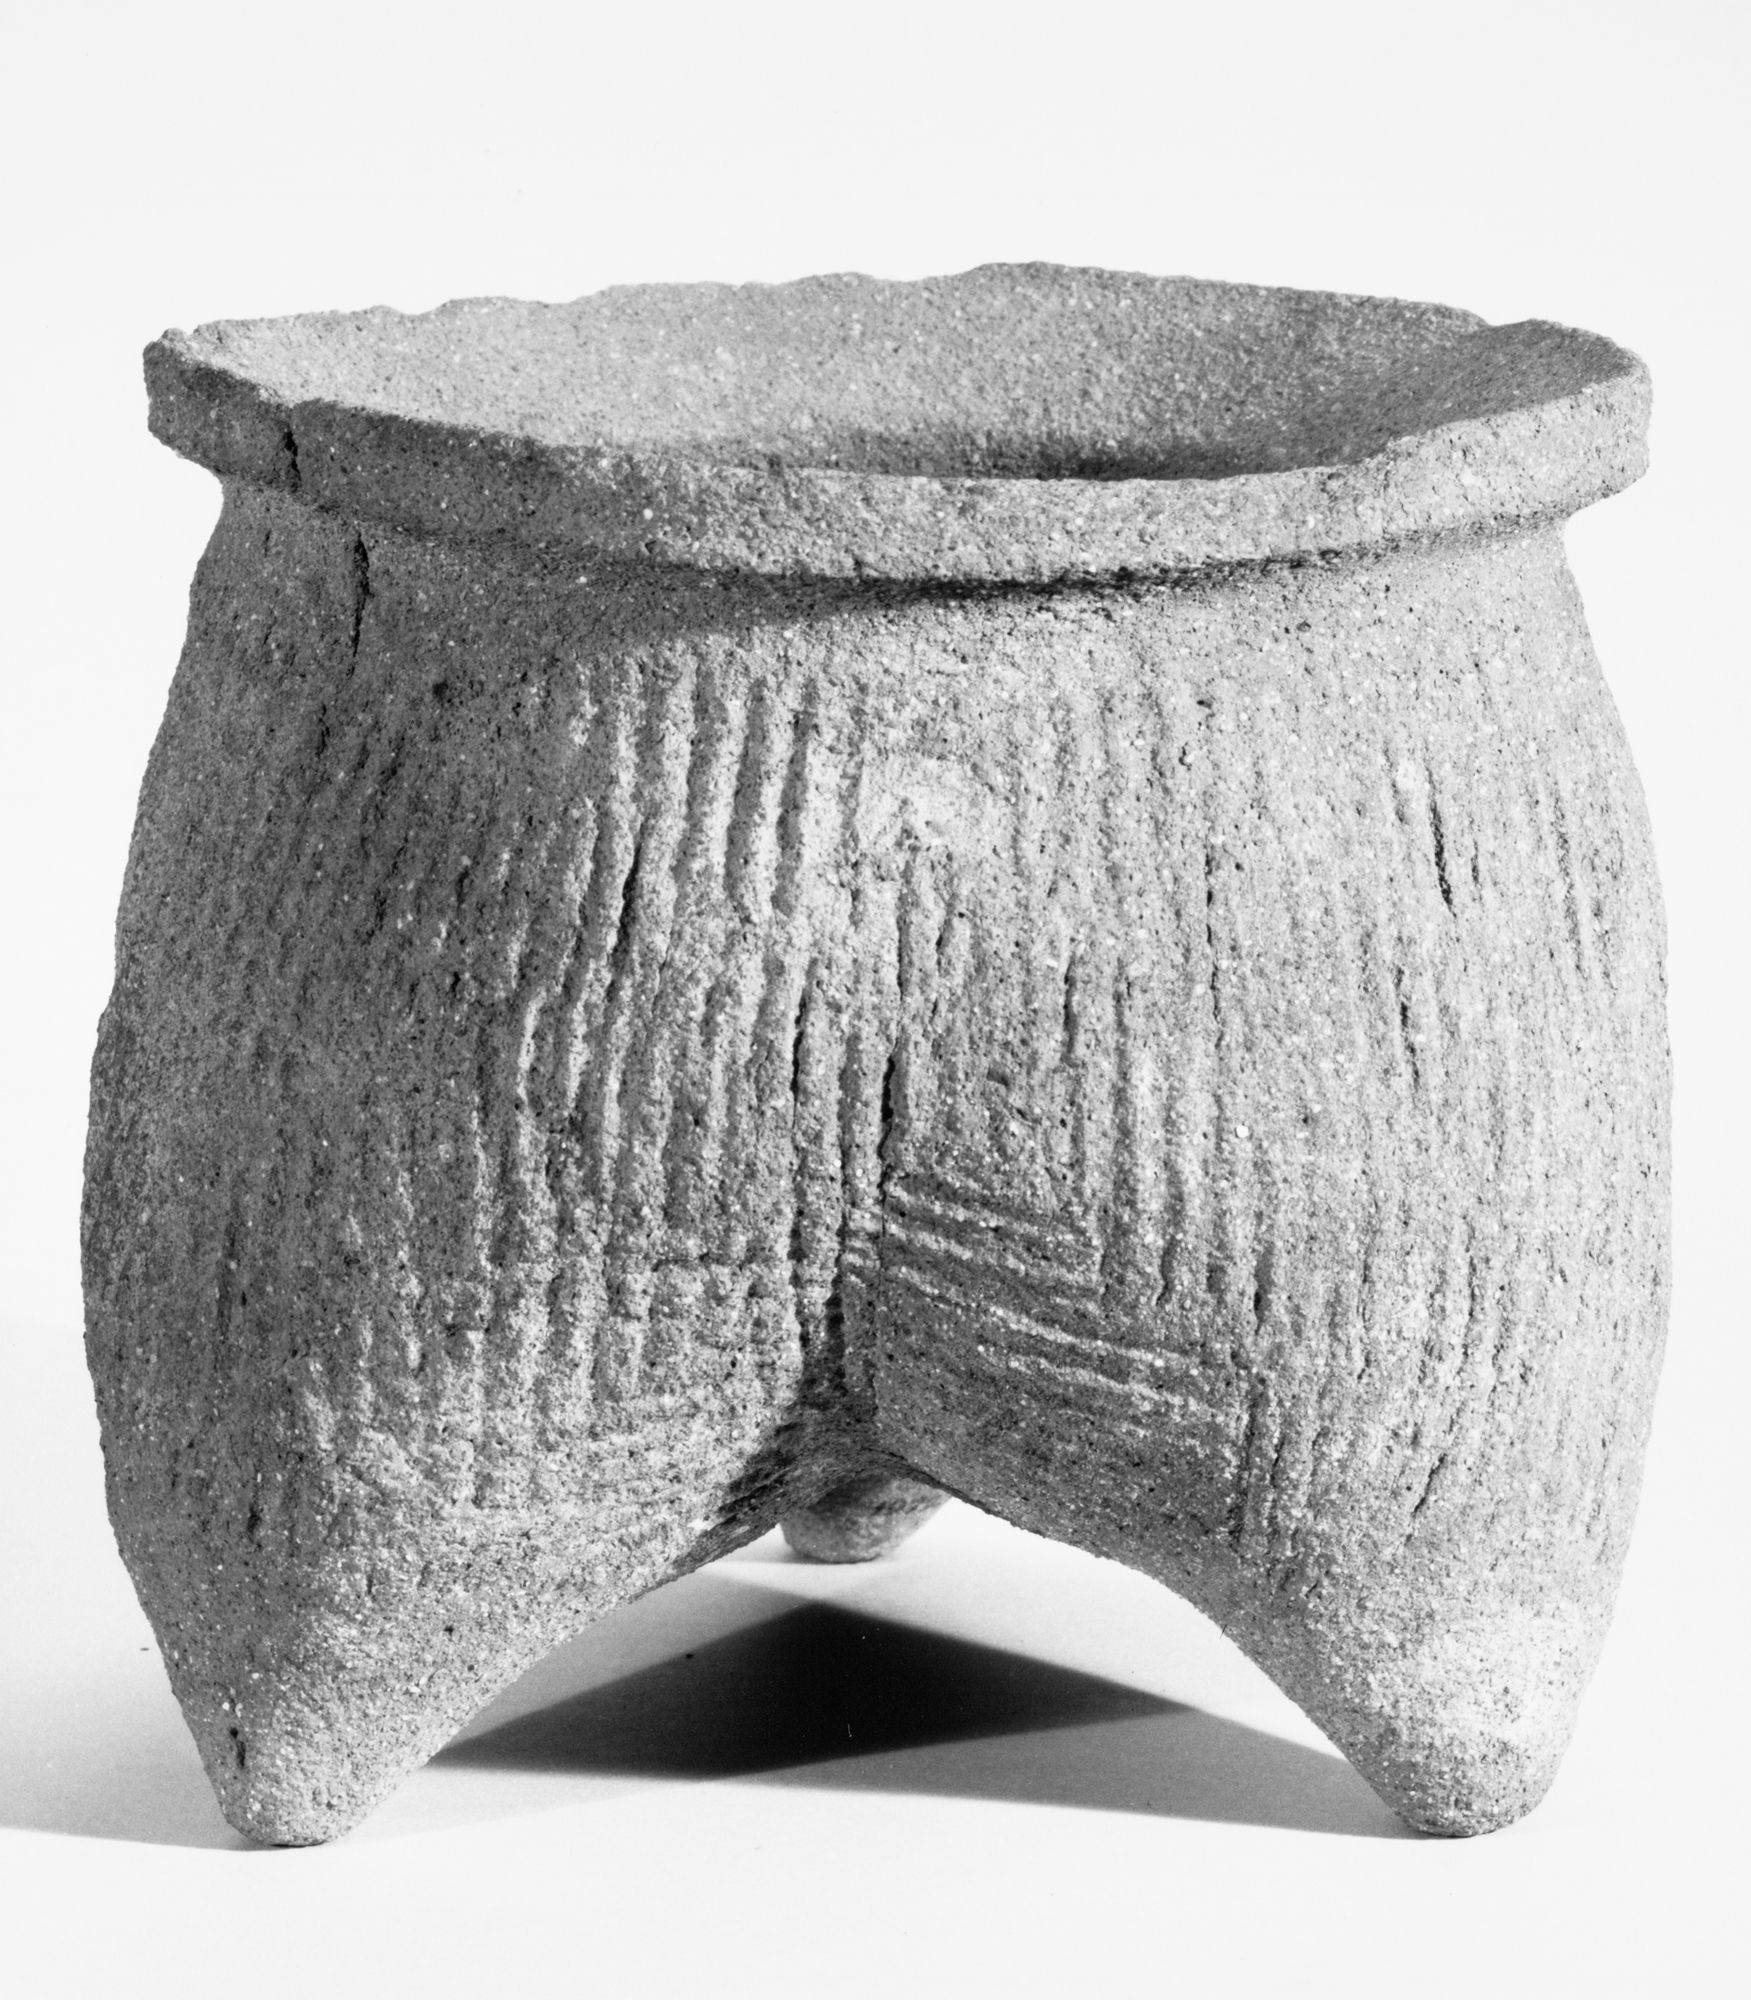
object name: tripod cooking vessel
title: Tripod Cooking Vessel (Li)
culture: chinese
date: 1300-1001 BCE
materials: cord, earthenware